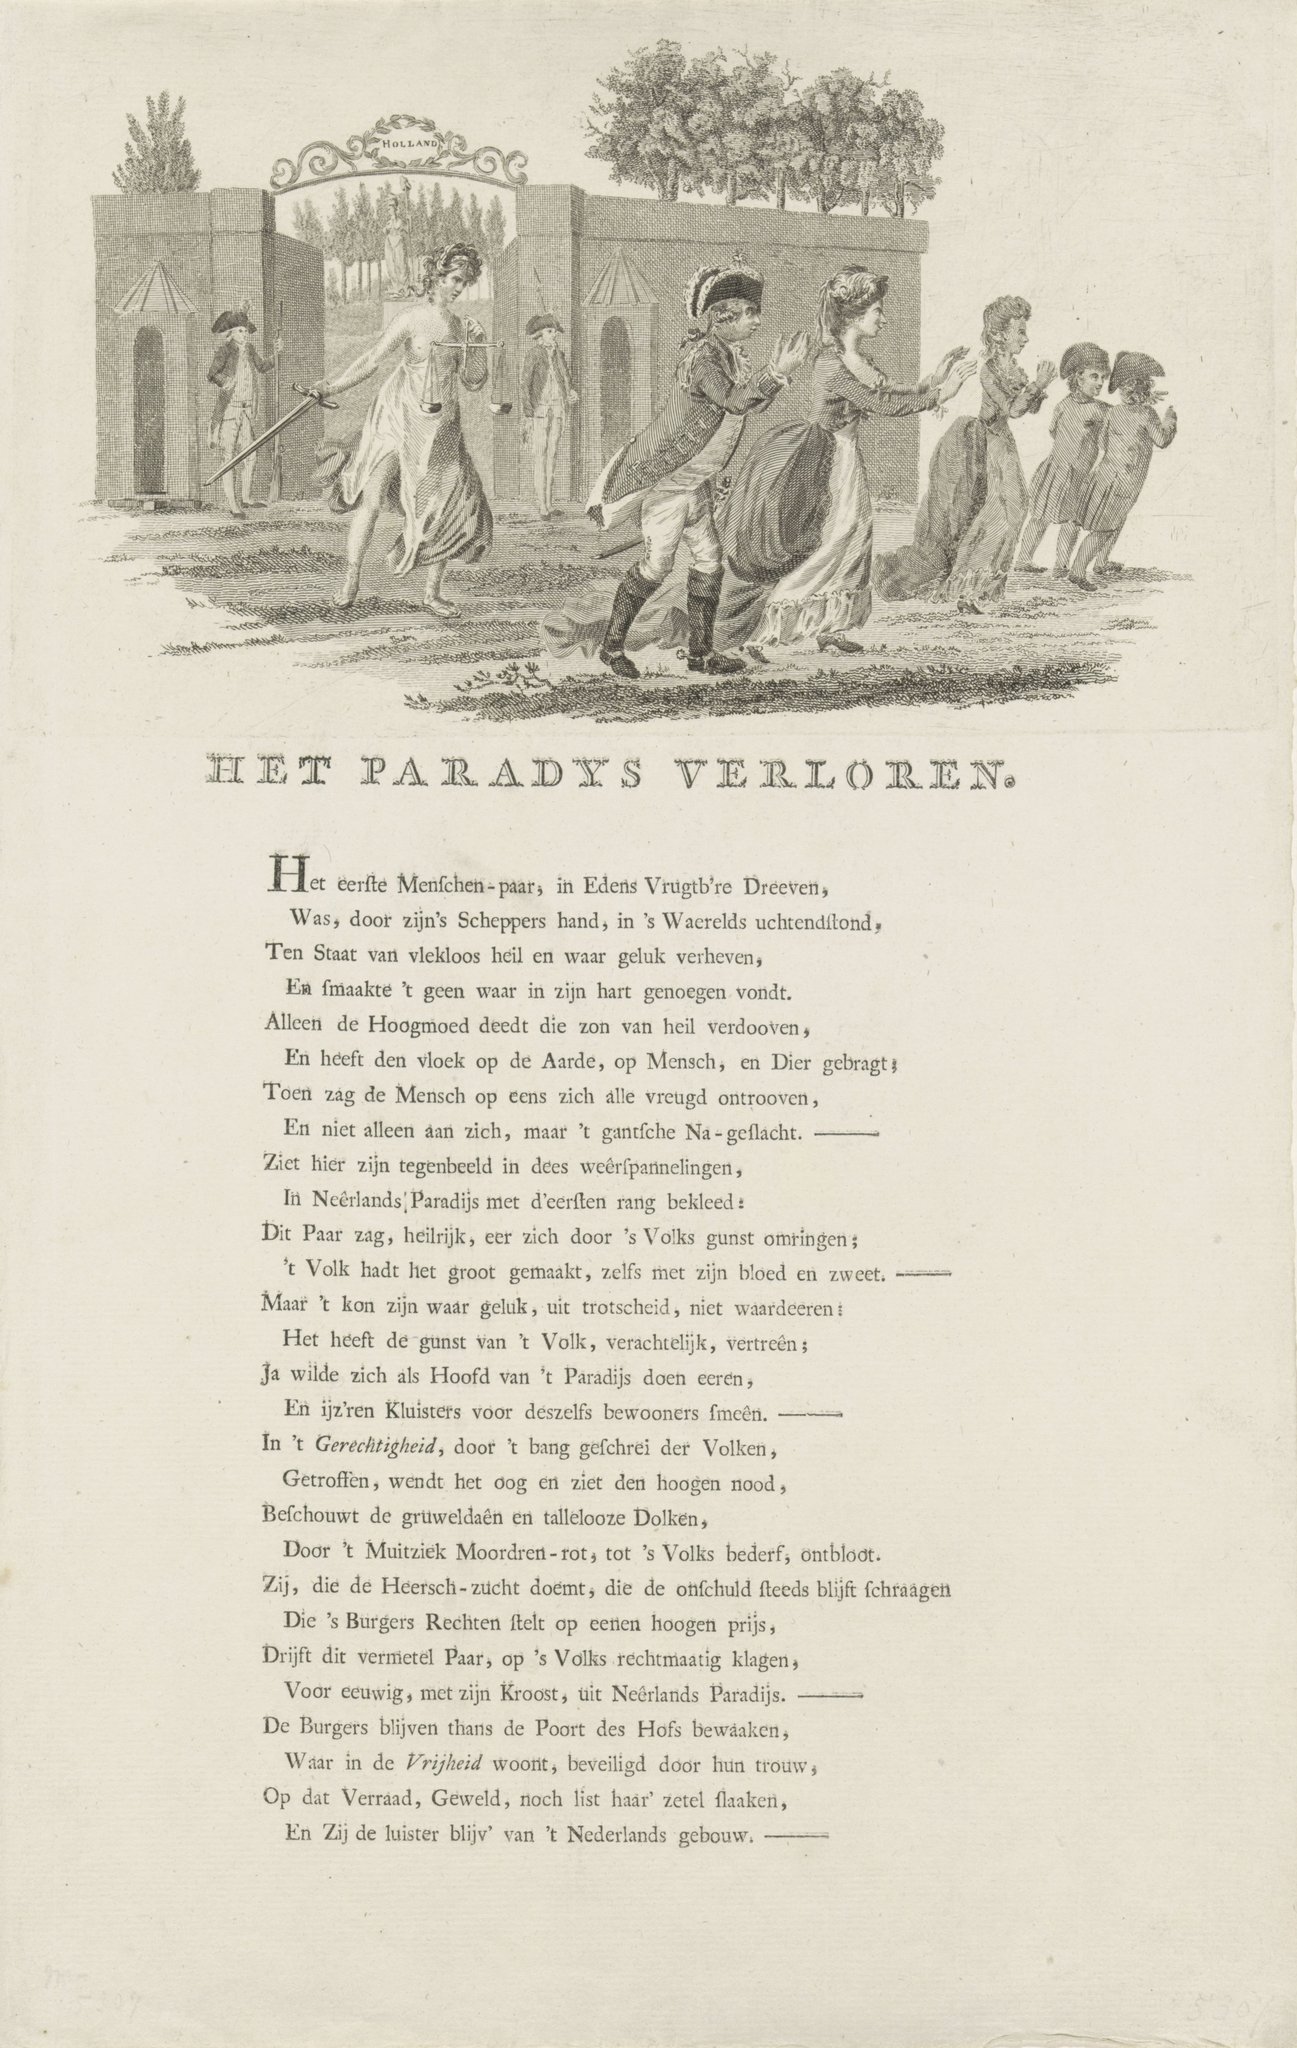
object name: cartoon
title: Het Paradys Verloren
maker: Anonymous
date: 1795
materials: paper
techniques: engraving, etching, letterpress printing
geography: northern netherlands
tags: william v (prince of orange), william i of the netherlands, painter, draughtsman, wilhelmina of prussia (princess of orange), louise (prinses van oranje-nassau), the hague, willem george frederik (prins van oranje-nassau), justice, 'justitia'; 'giustitia divina' (ripa) ~ one of the four cardinal virtues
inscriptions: collector's mark: Lugt 2228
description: Spotprent waarin de stadhouderlijke familie door de Gerechtigheid verjaagd wordt uit een ommuurde hof aangeduid als: Holland. Parallel met Adam en Eva die door de Engels Gods uit het Paradijs worden verjaagd. Naar aanleiding van de vlucht van Willem V naar Engeland op 18 januari 1795. Op het blad onder de plaat een vers van 28 regels.